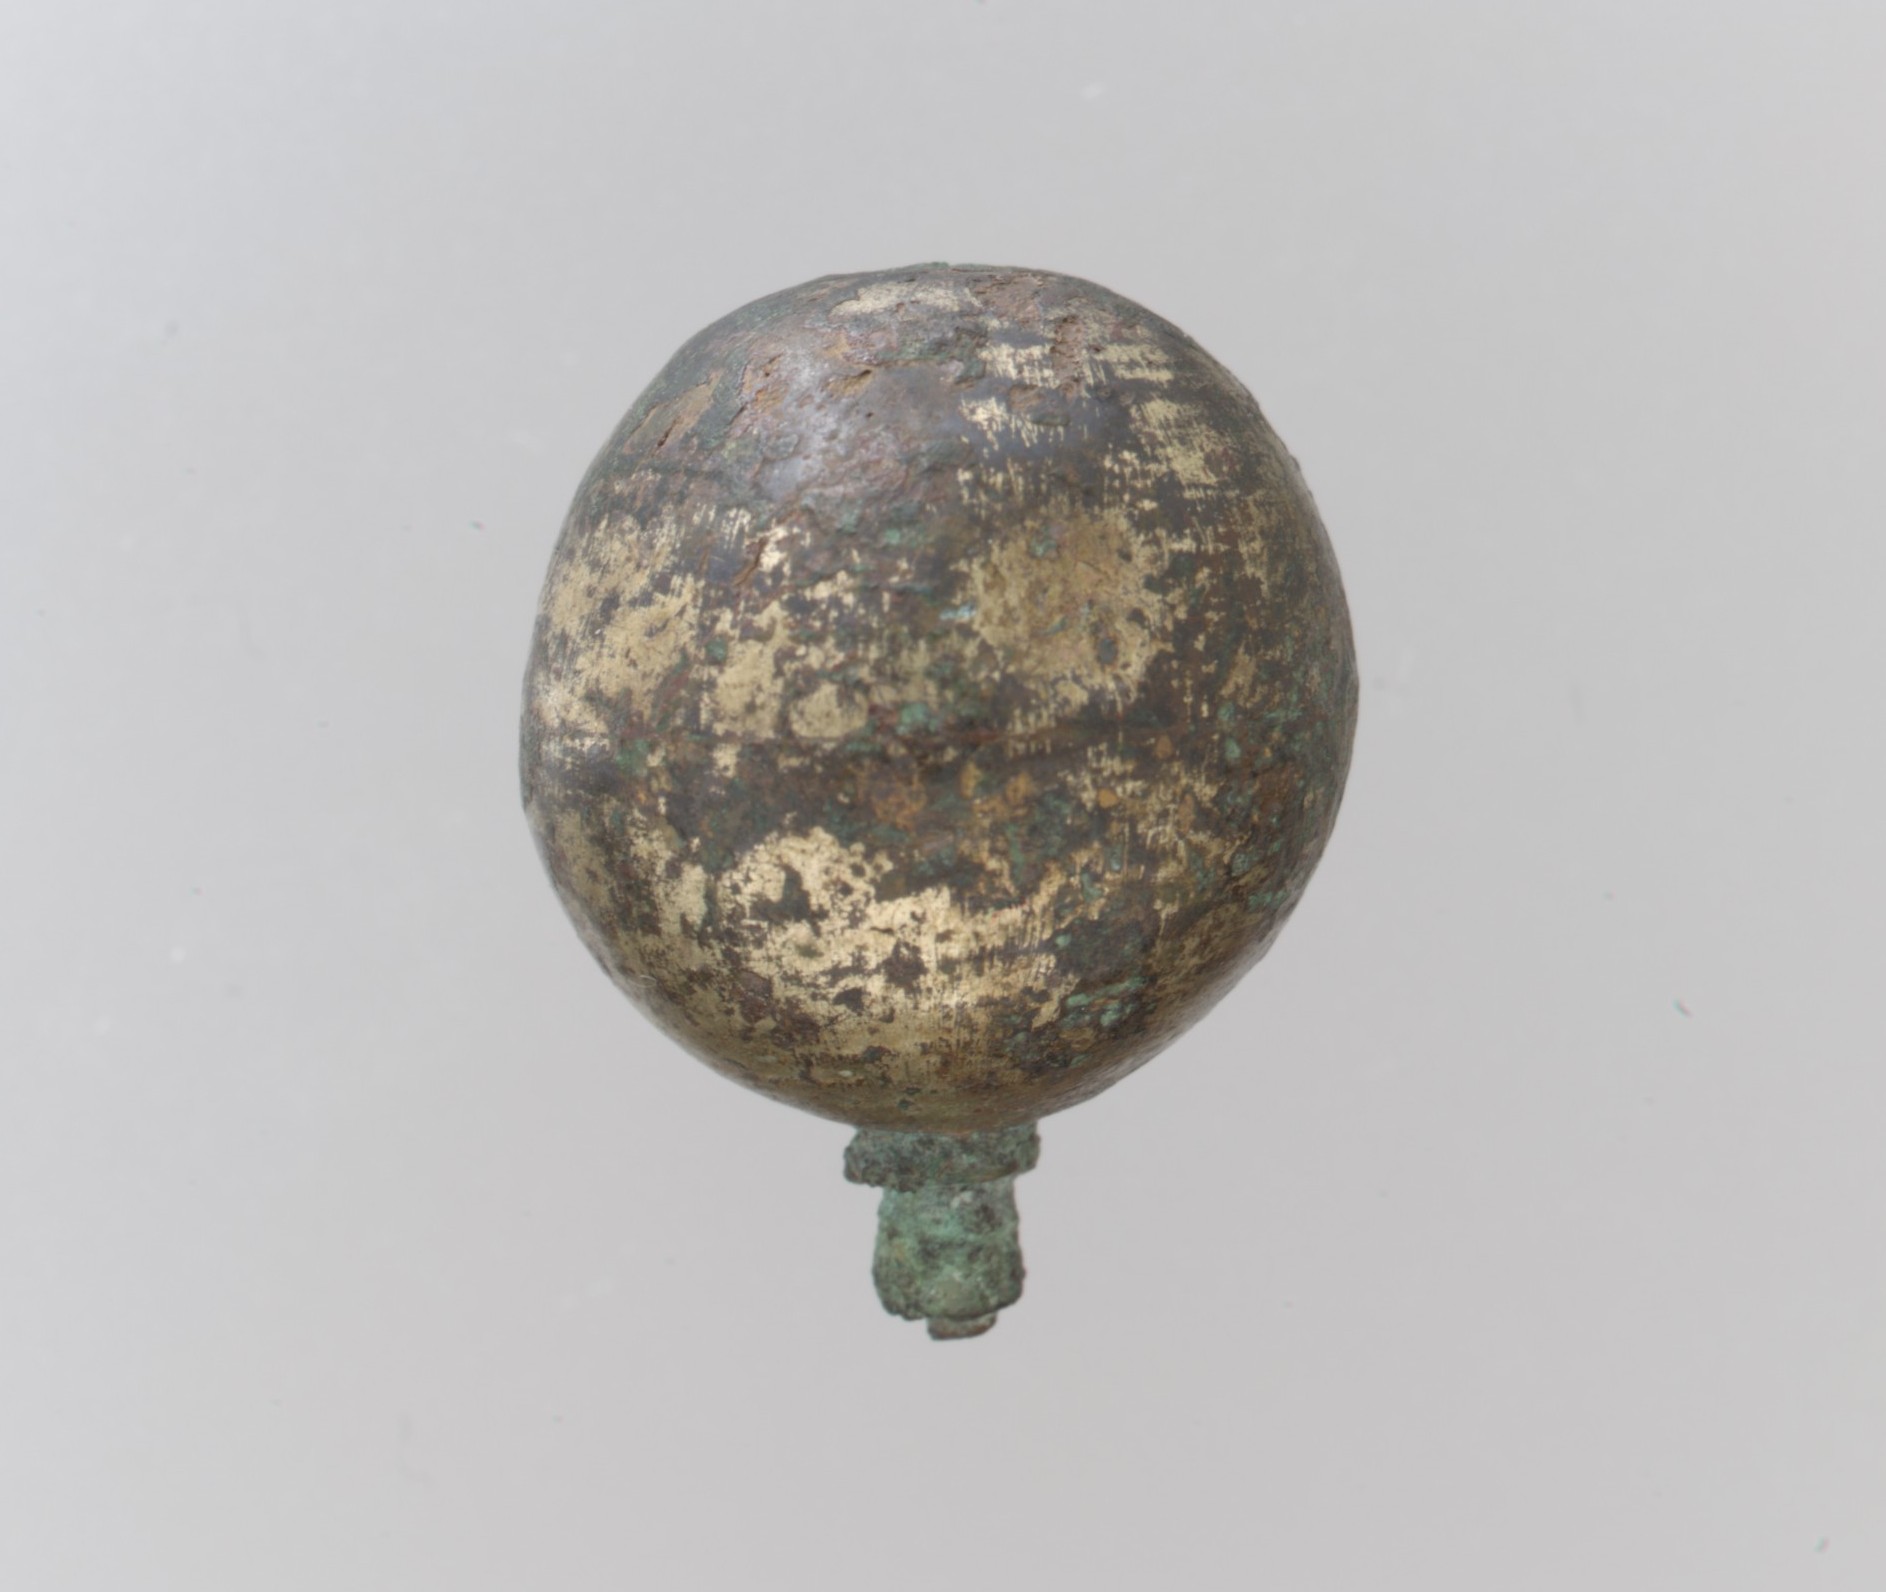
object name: knob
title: Hairpin Knob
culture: roman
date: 1-400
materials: bronze, gilt